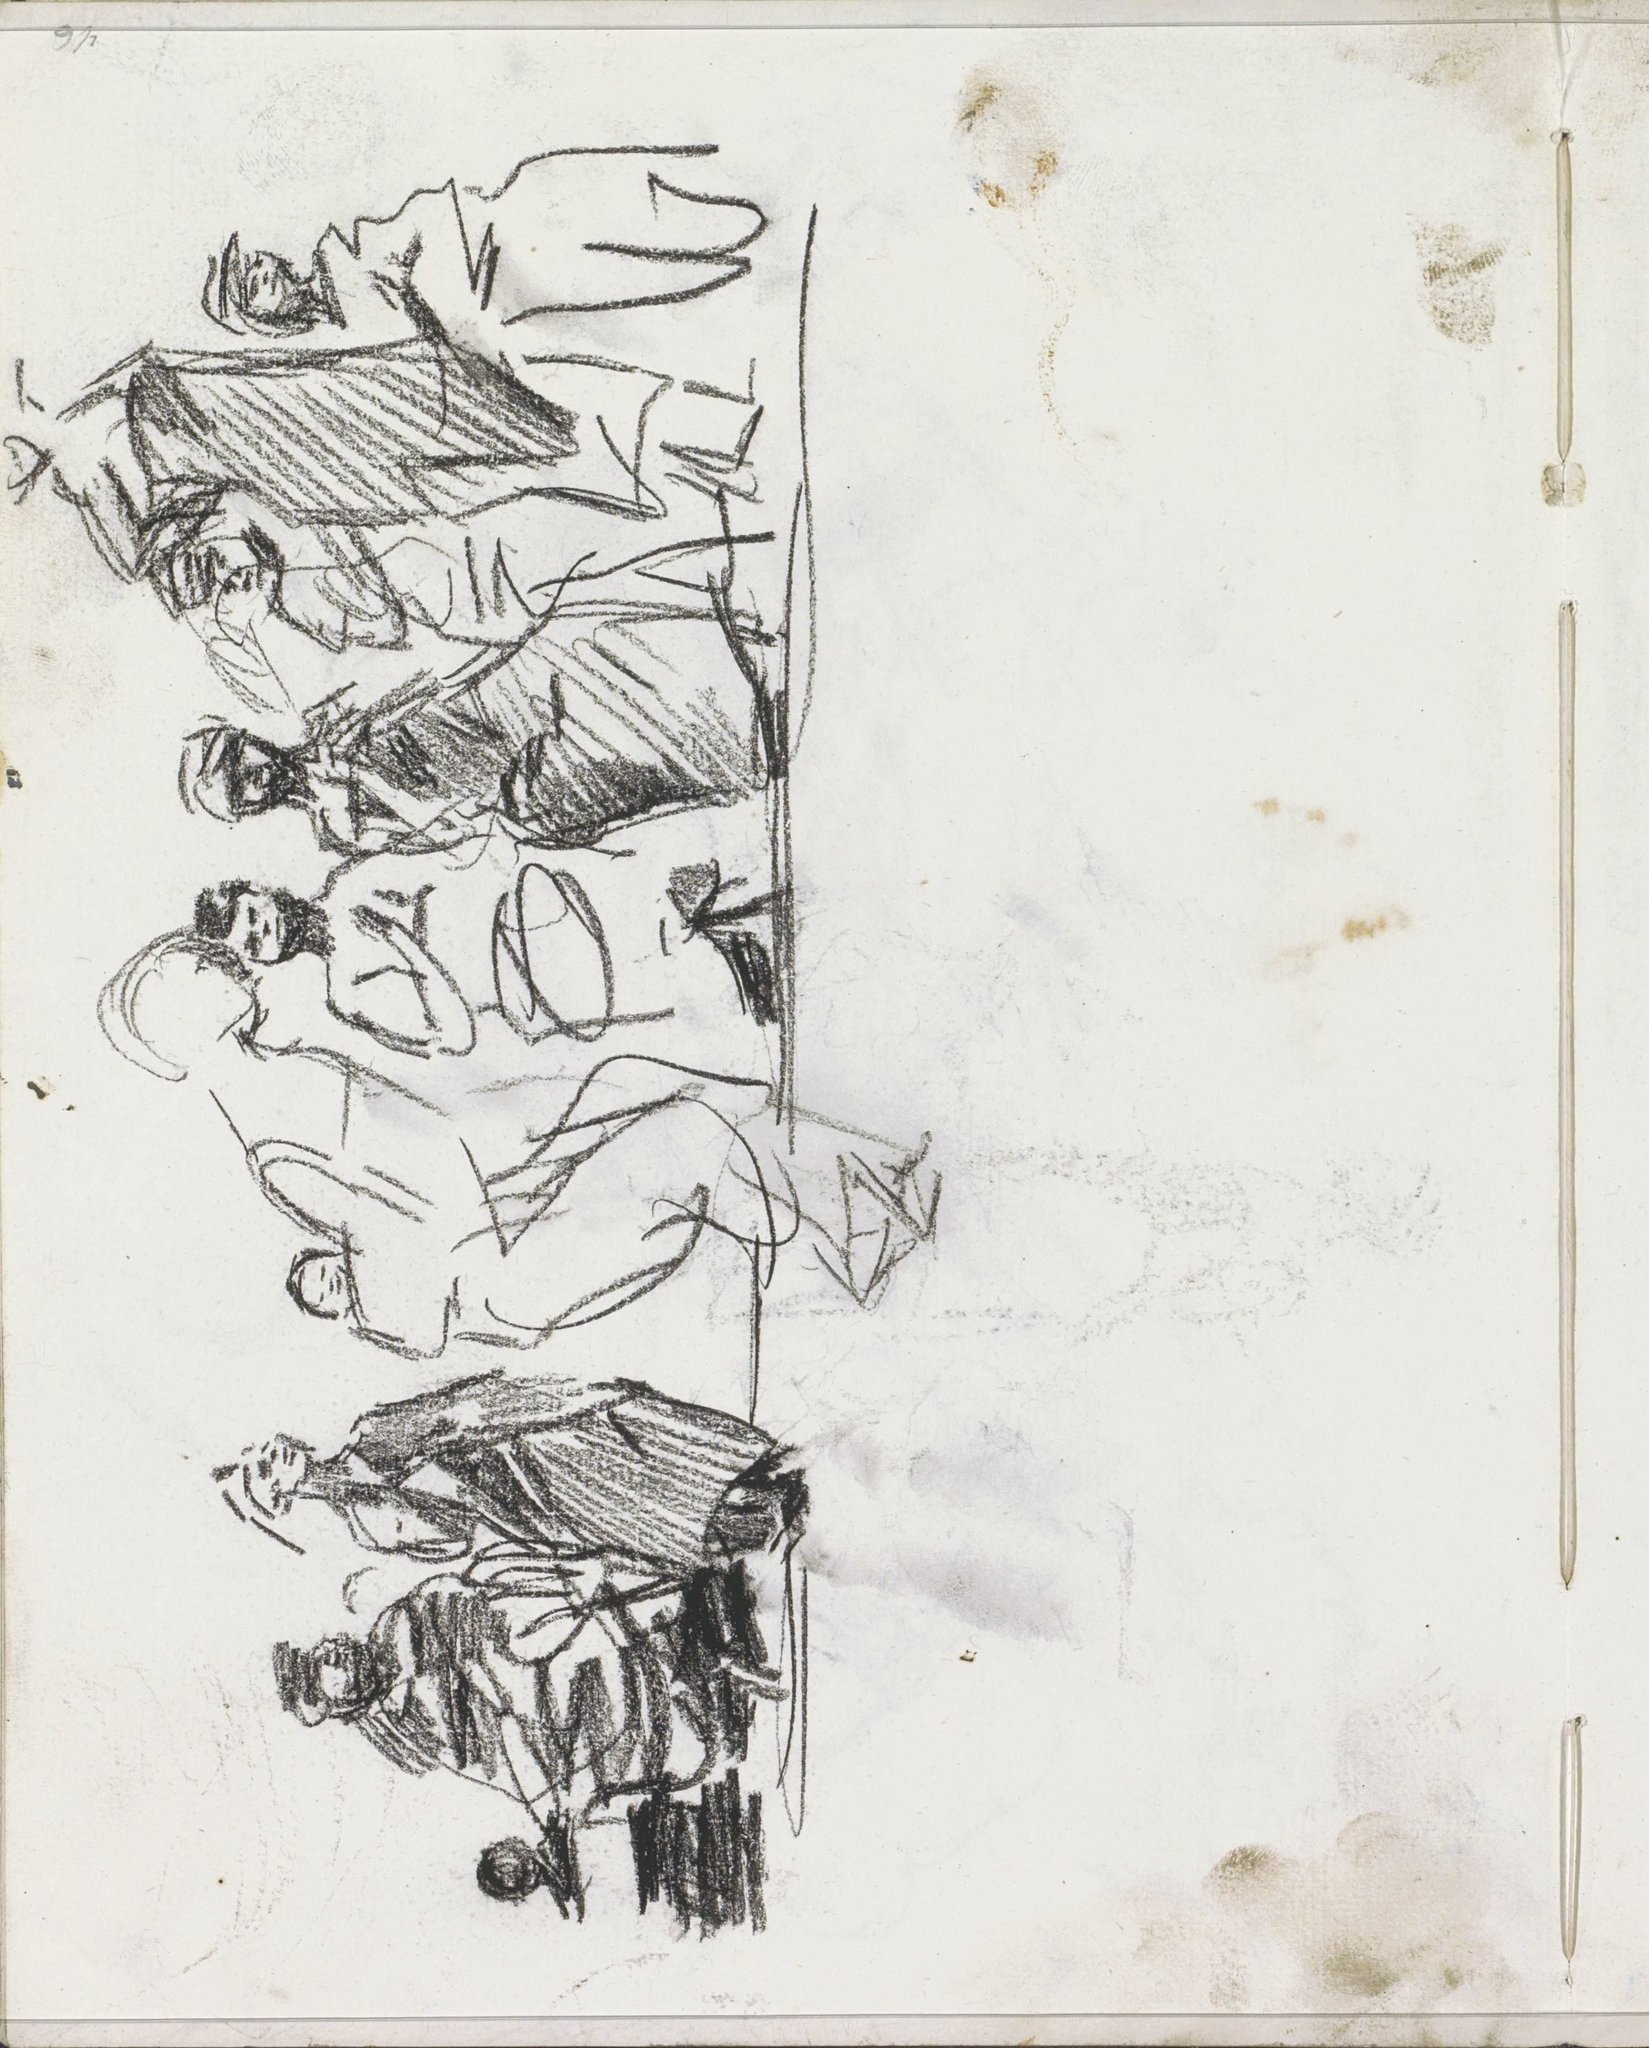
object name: sketchbook leaf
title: Musicerende figuren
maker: isaac israels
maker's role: draughtsman, painter, print maker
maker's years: 1865-1934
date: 1875-1934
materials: chalk, paper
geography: the hague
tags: musician at work, dancing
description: Ervoor mogelijk een dansende figuur. Blad 5 verso uit schetsboek XIII met 25 bladen.